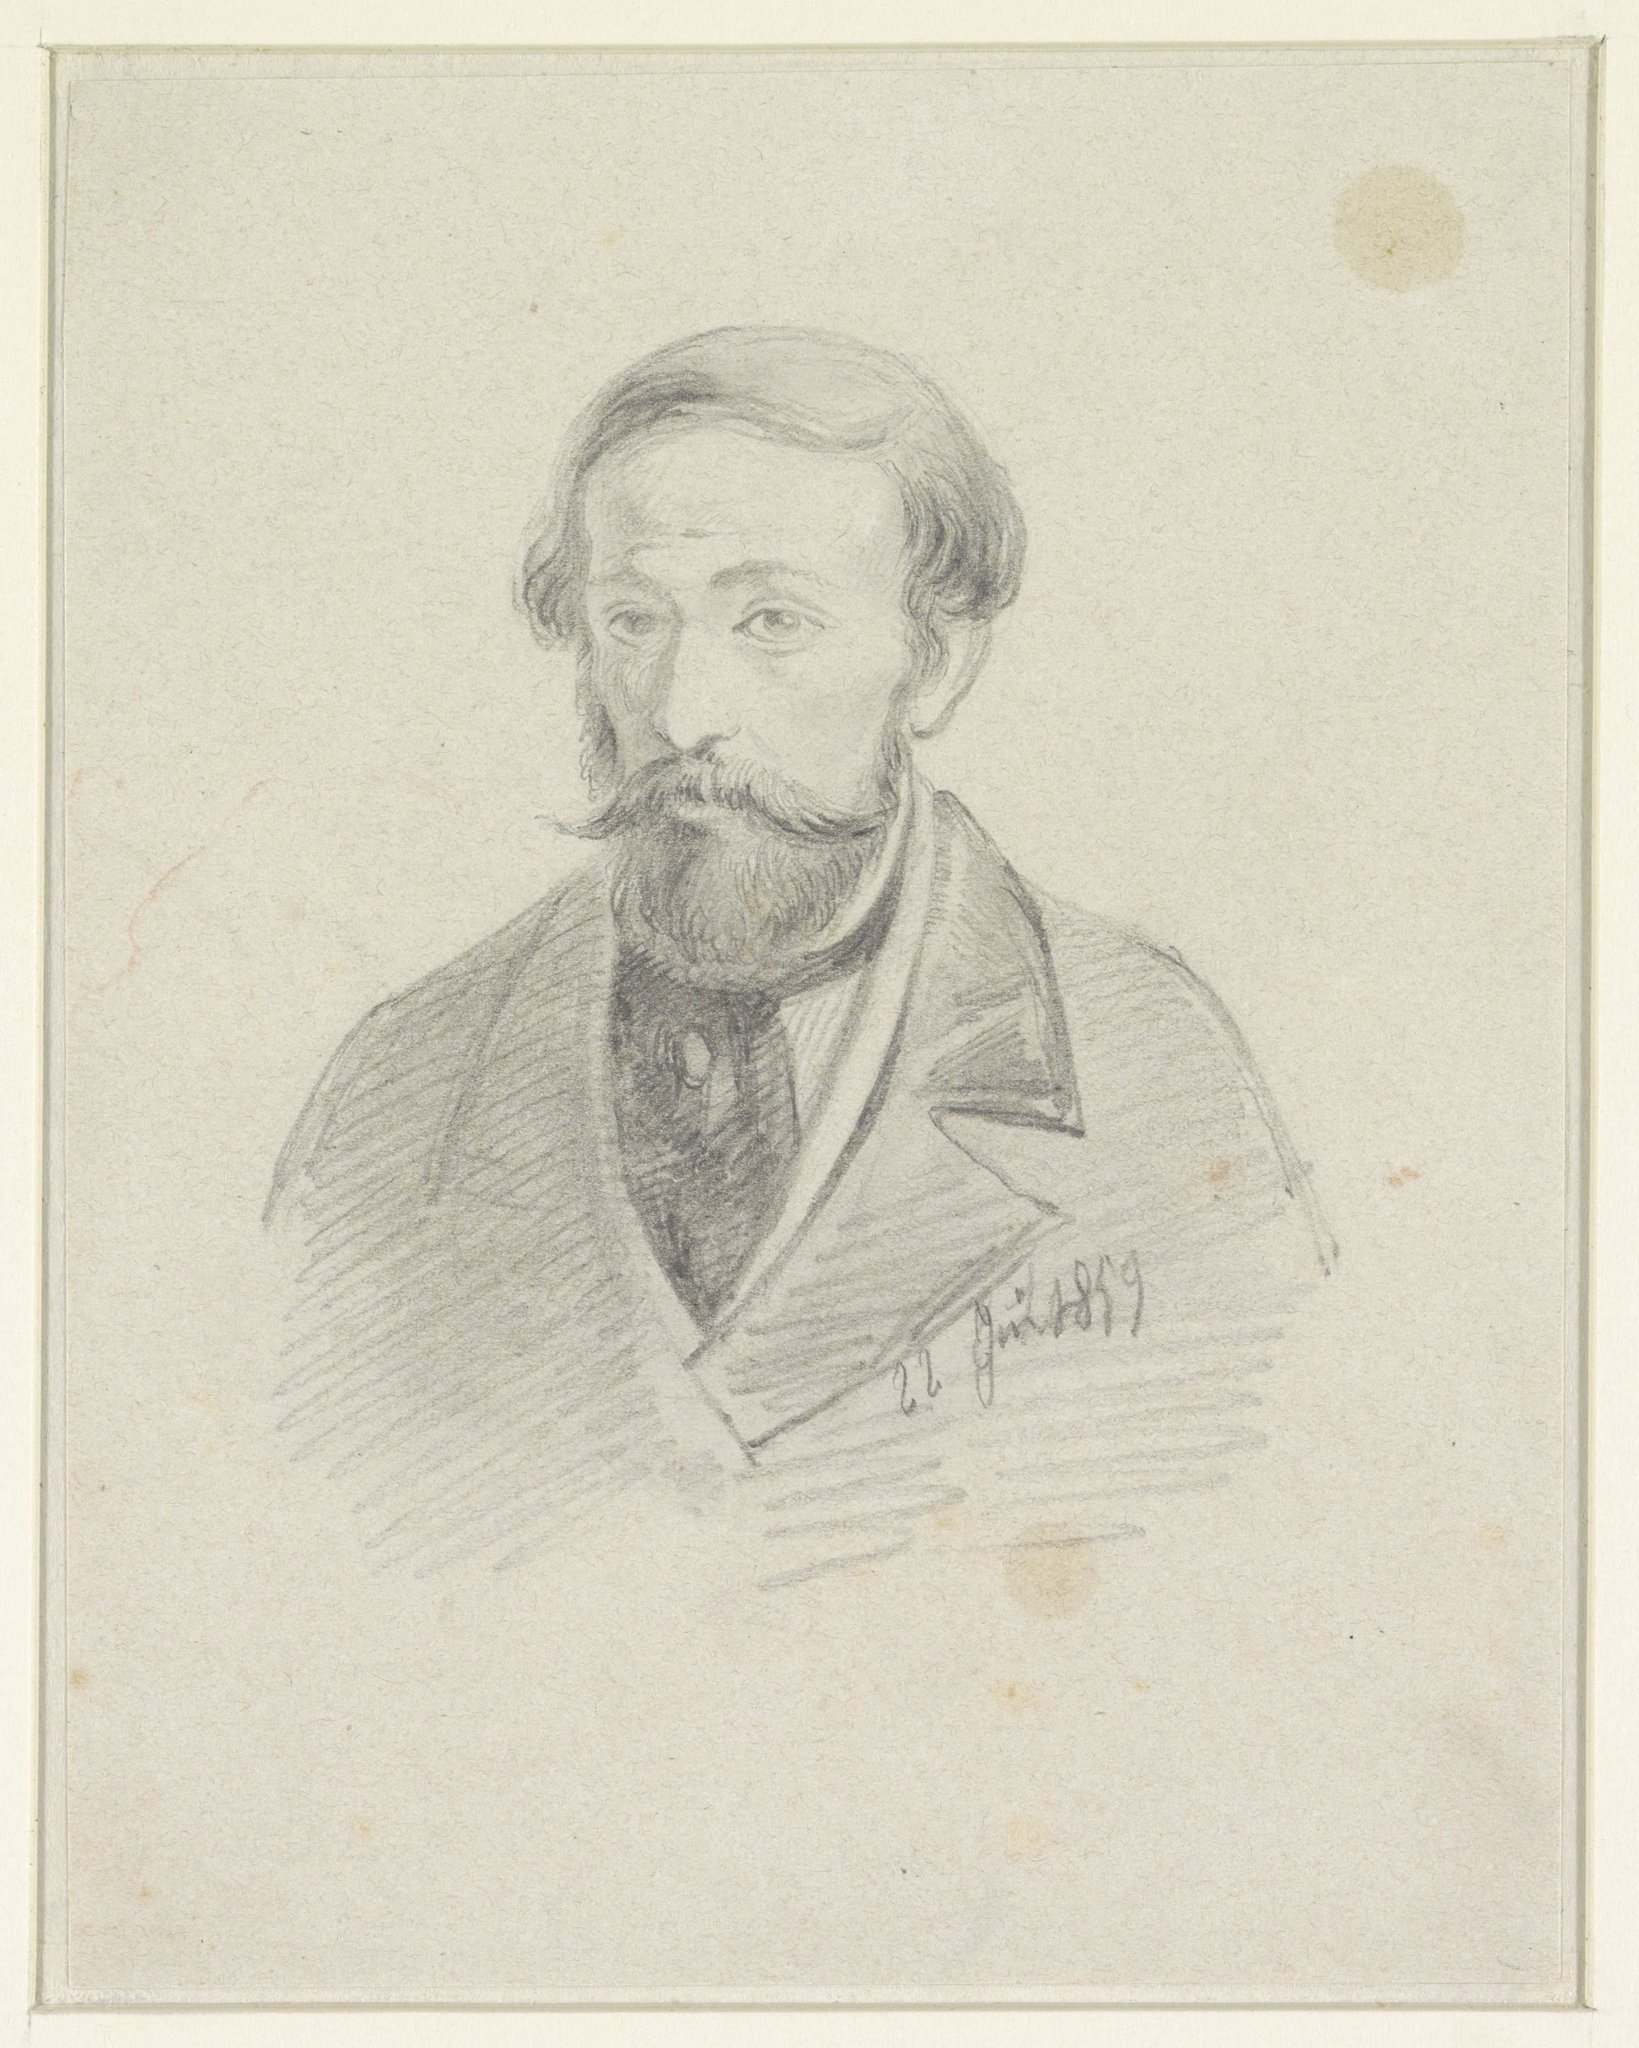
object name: design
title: Zelfportret van Egidius Linnig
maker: egidius linnig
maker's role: draughtsman, print maker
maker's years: 1821-1860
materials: paper, pencil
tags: antwerp, print maker, egidius linnig, portrait, self-portrait of artist, portrait, self-portrait of graphic artist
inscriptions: date